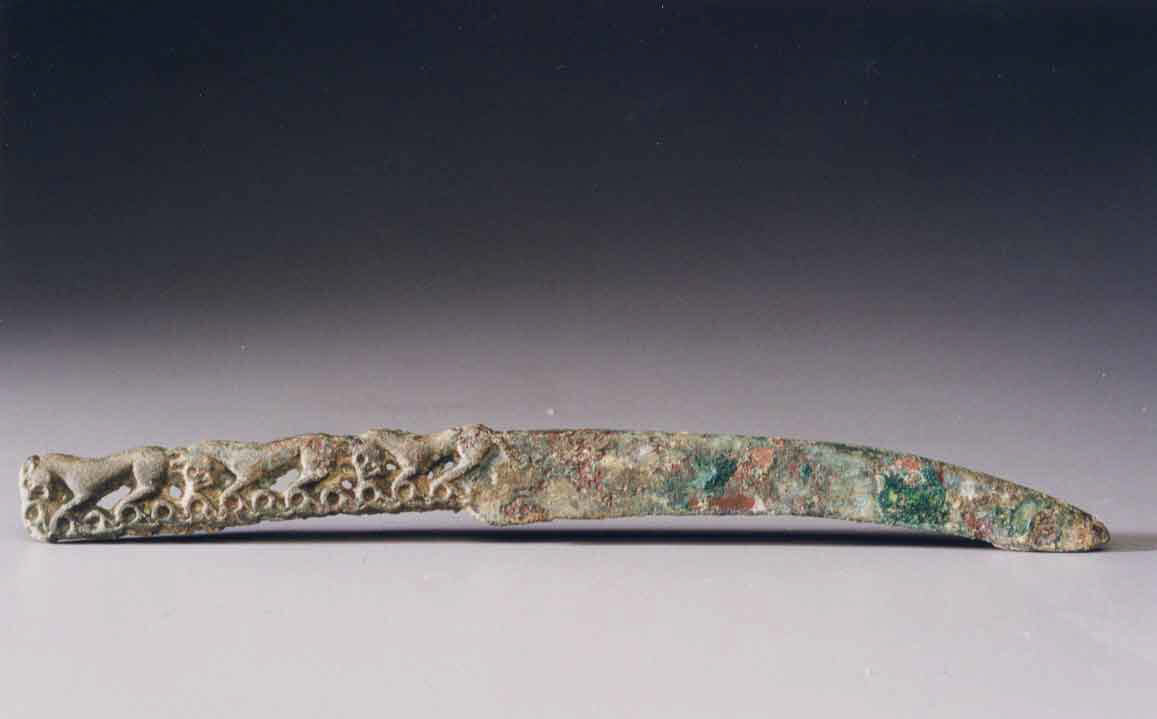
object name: knife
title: Knife with Zoomorphic Decoration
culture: eastern central asian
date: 600-501 BCE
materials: bronze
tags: animals,knives